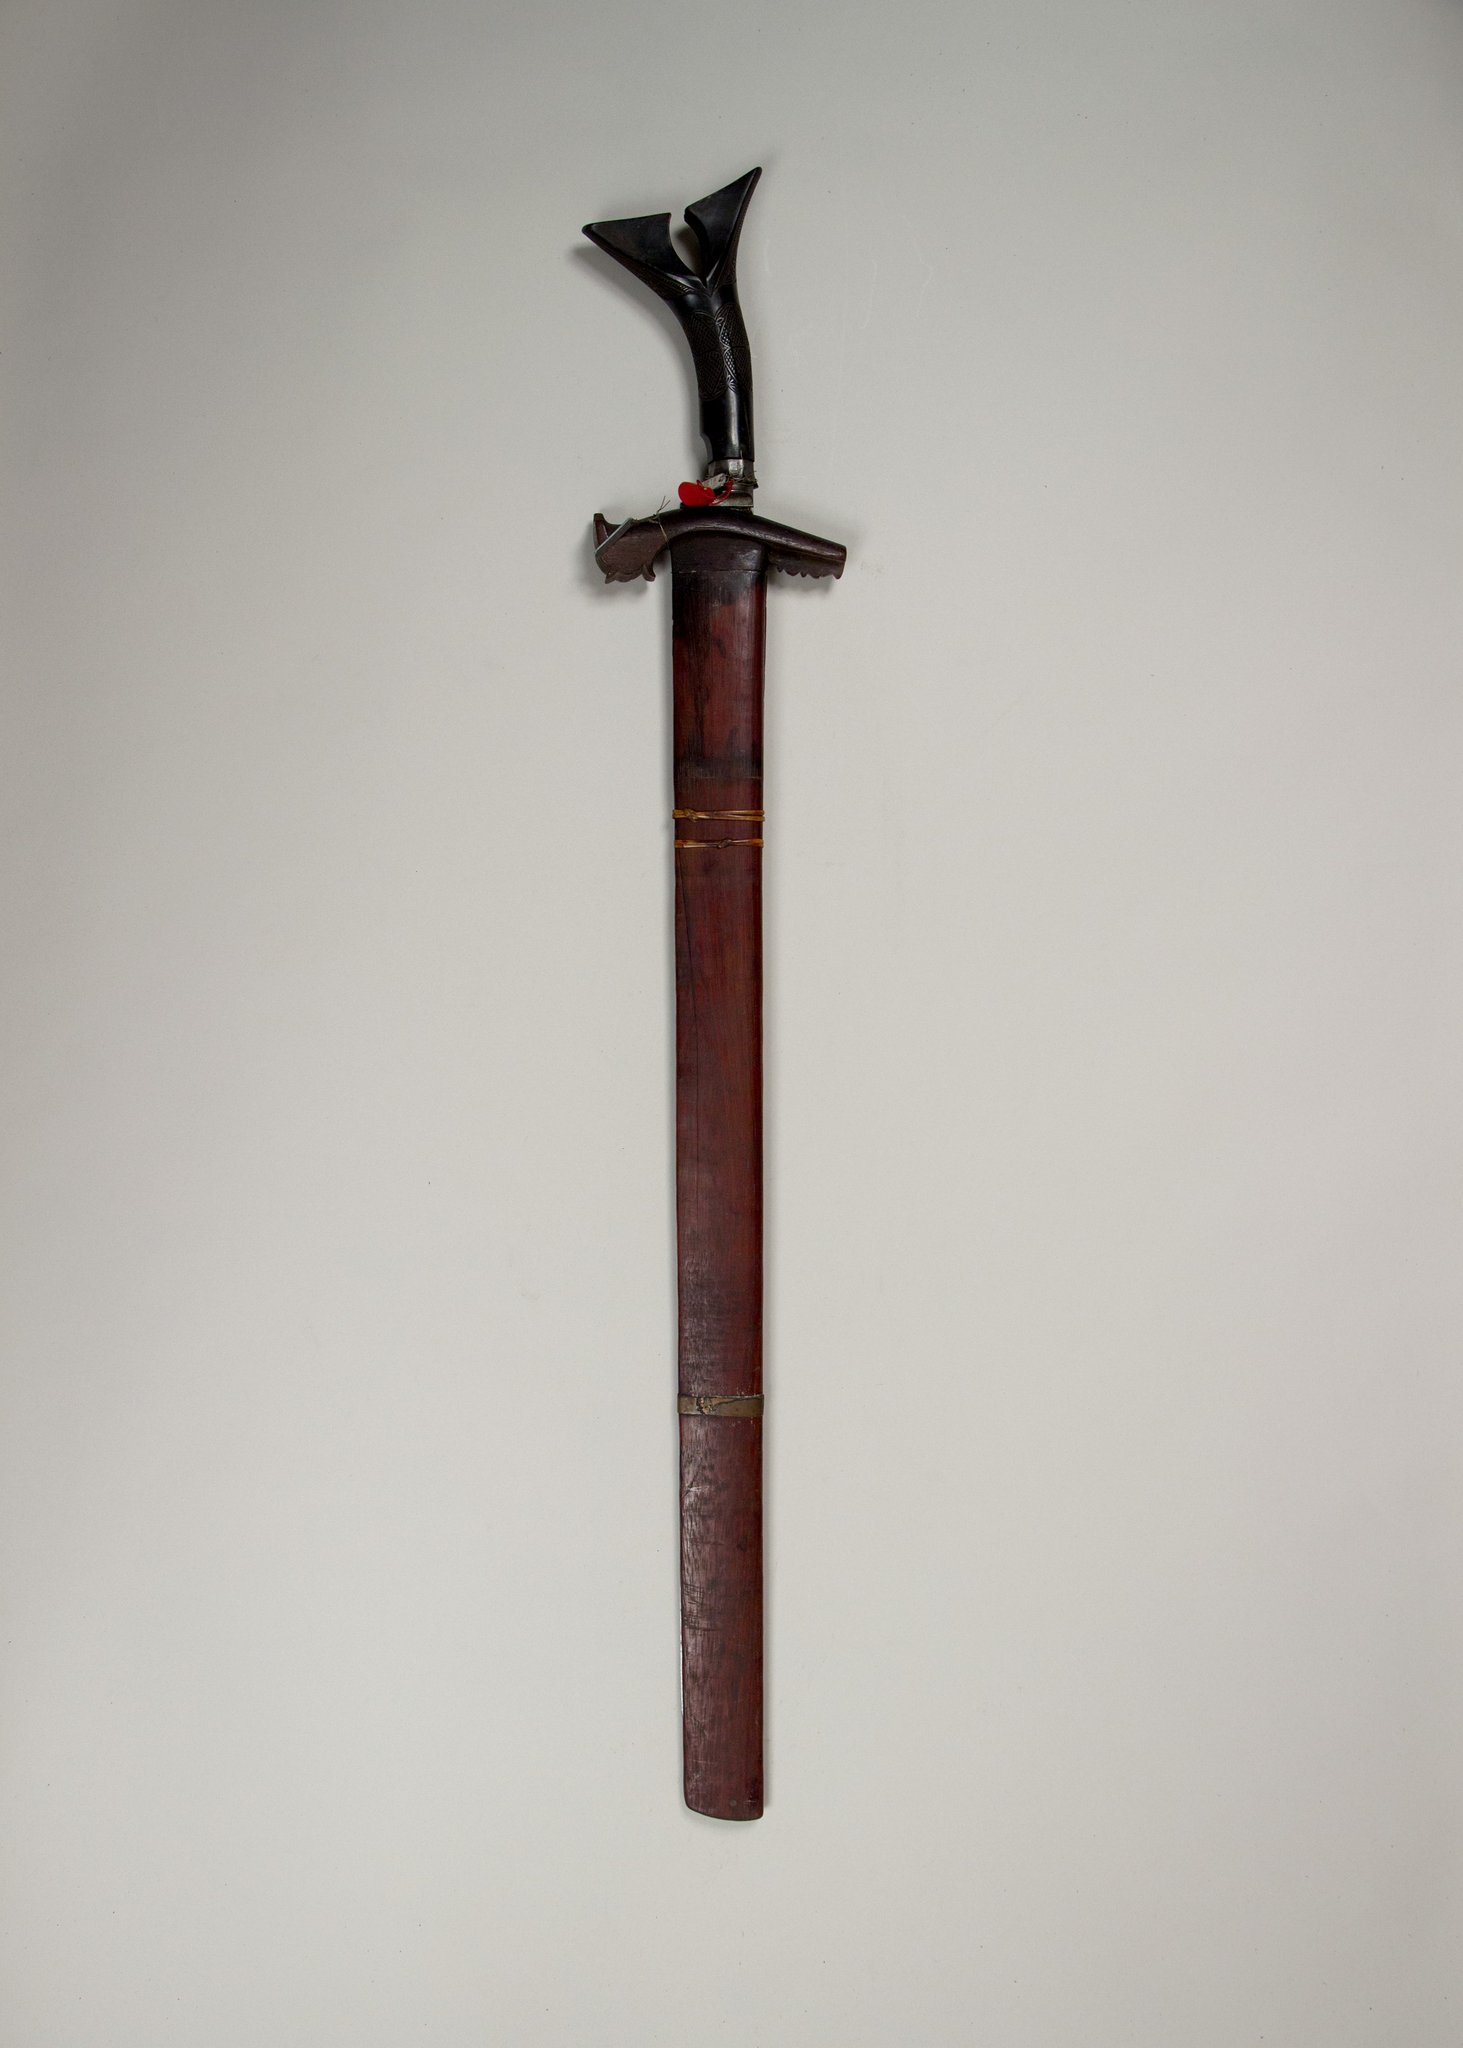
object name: sword with scabbard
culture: acheen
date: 1501-1900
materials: horn, metal, rattan, wood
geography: indonesia